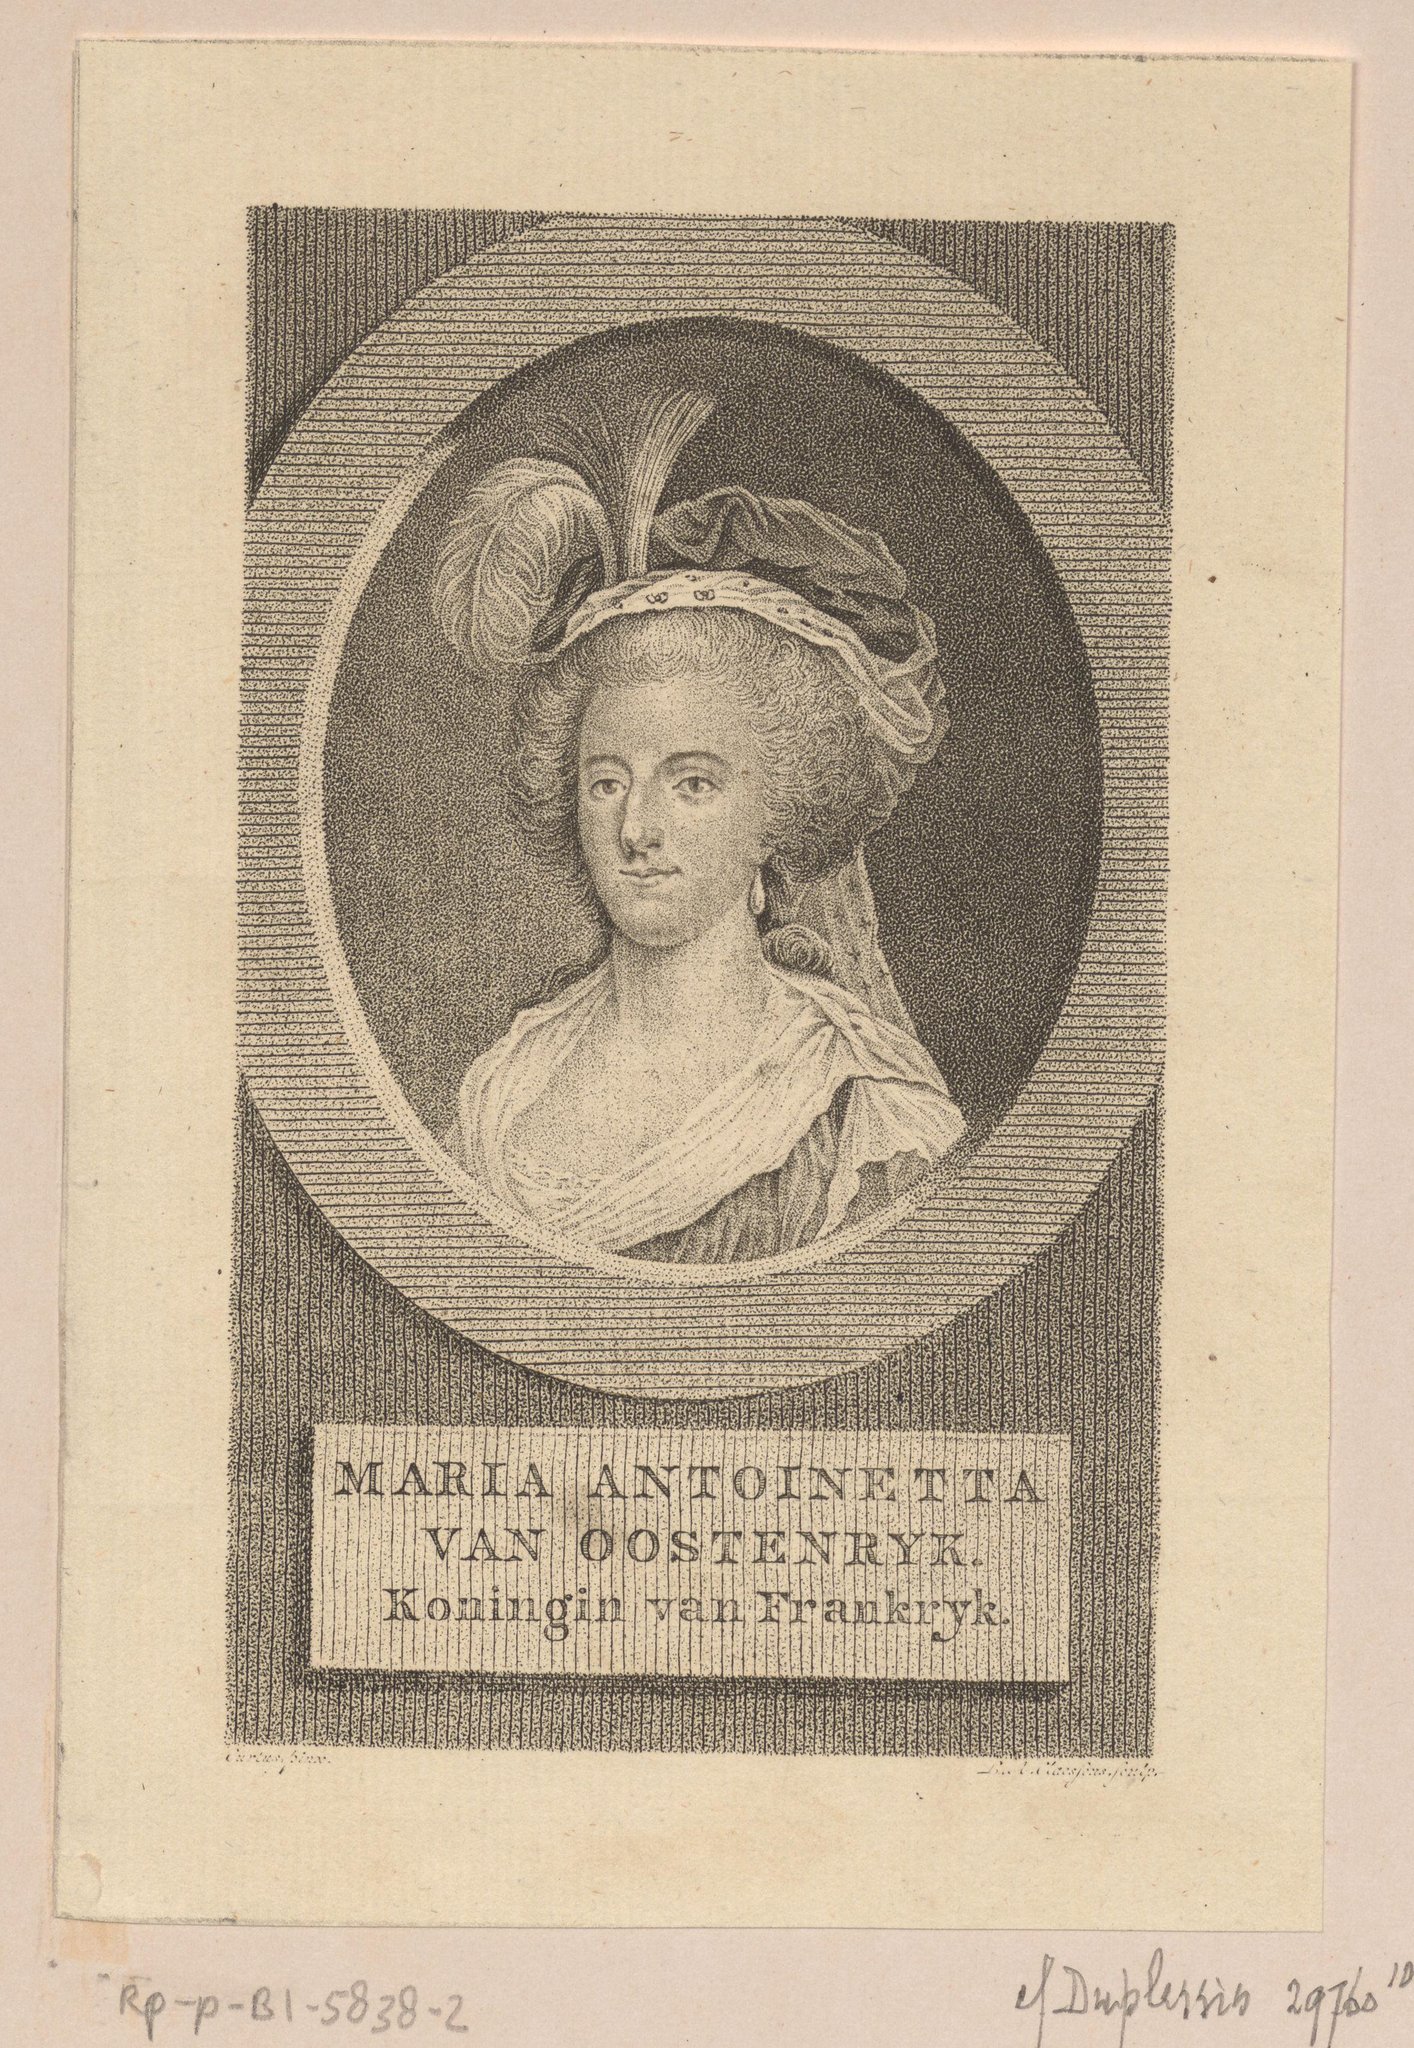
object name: print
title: Portret van Marie Antoinette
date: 1794-1809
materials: paper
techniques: engraving, etching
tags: vienna, paris, marie antoinette, historical persons - bb - woman, ornament ~ medallion, queen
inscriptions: name: ‘Curtus’, collector's mark: Lugt 2228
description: Prent waarschijnlijk uit een deel van: Tafereelen van de staatsomwenteling in Frankrijk. Amsterdam: Johannes Allart, 1794-1809.